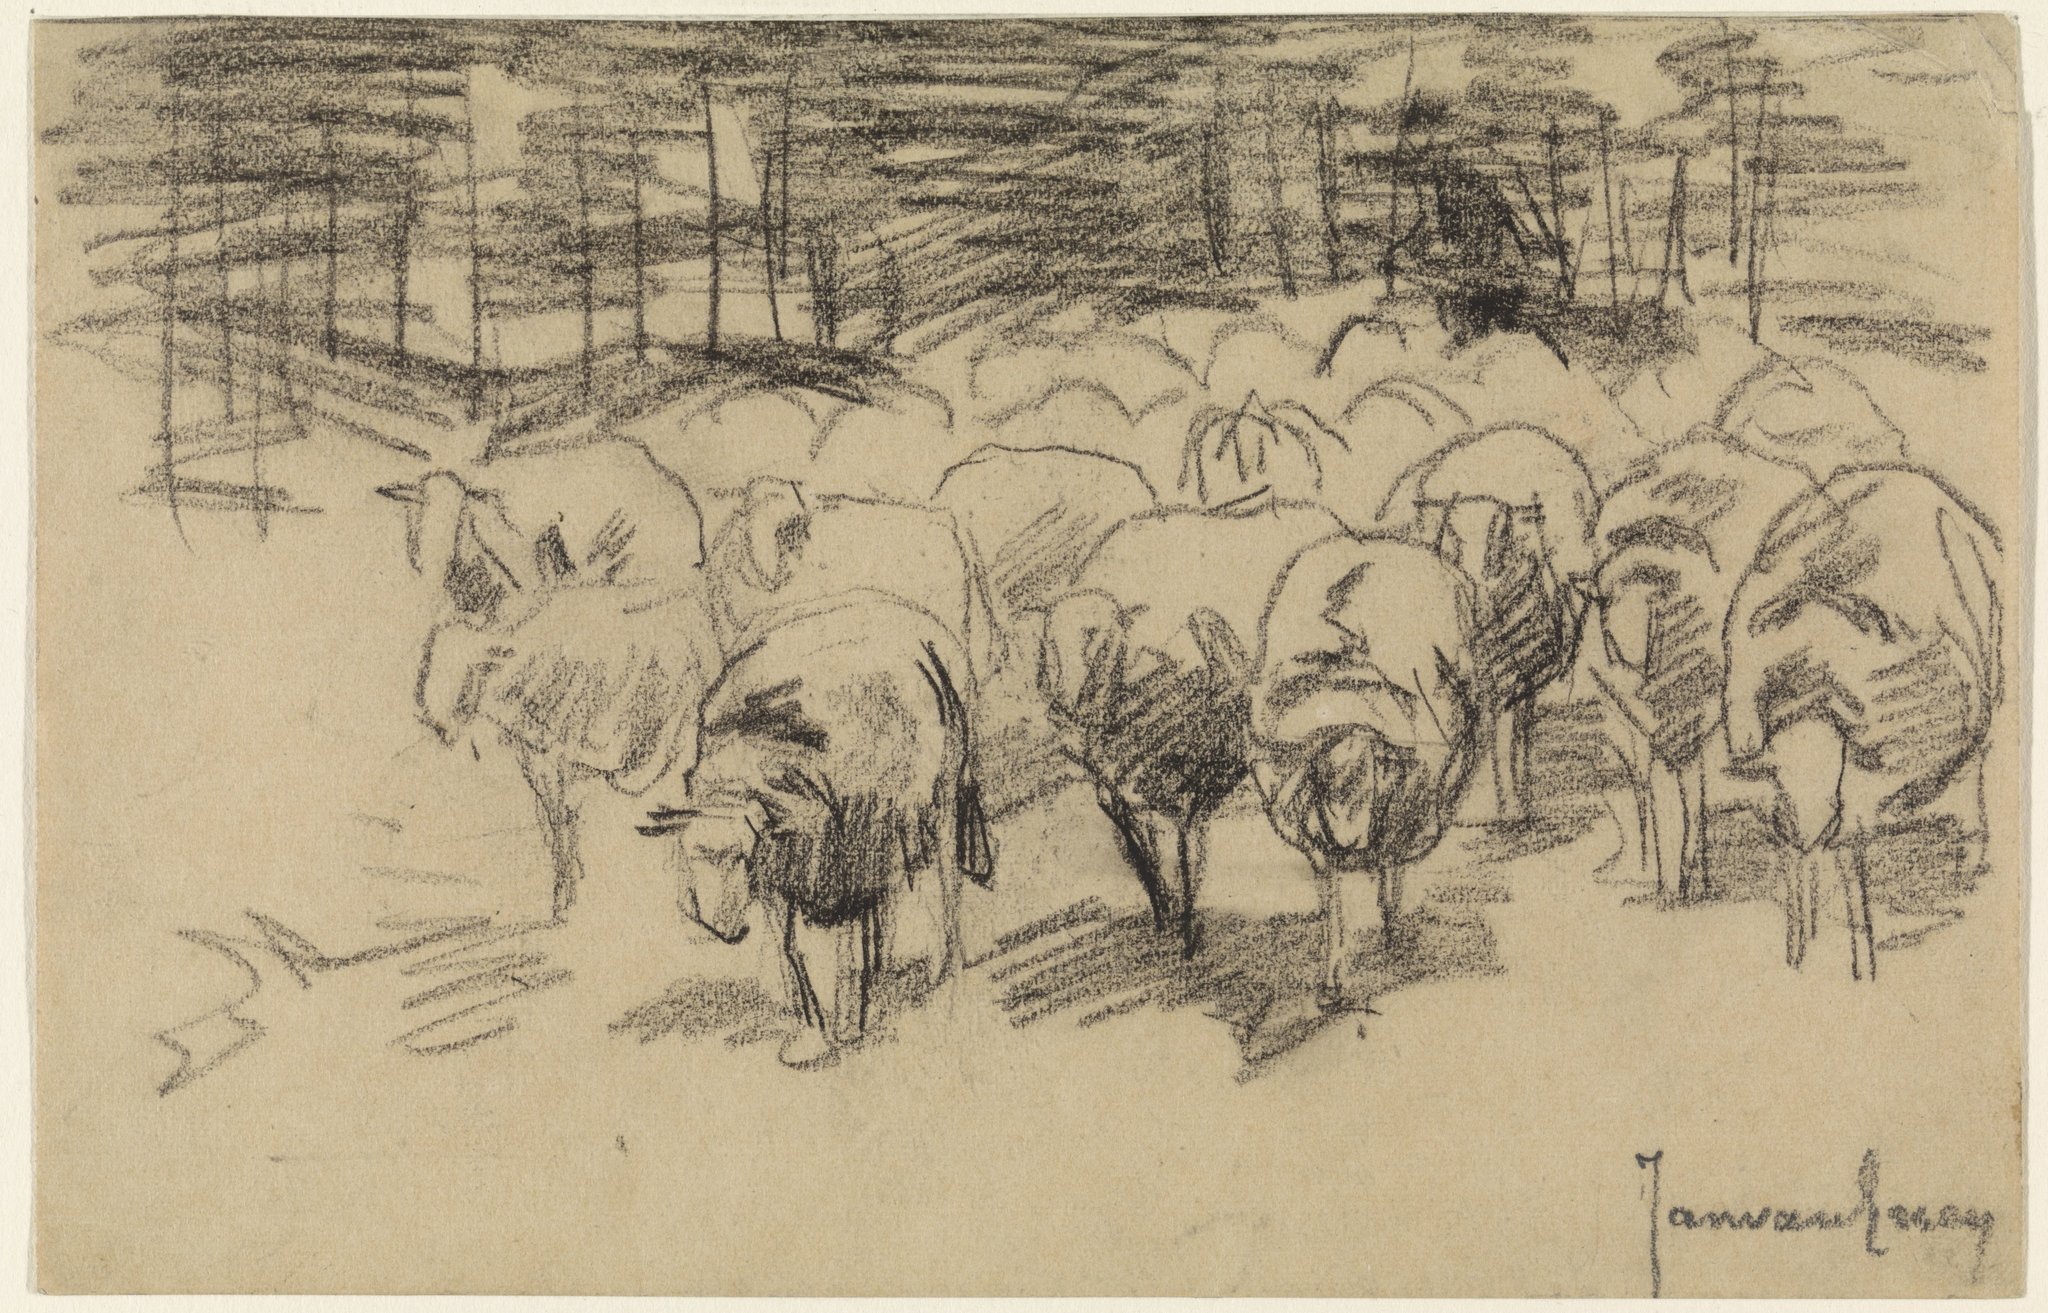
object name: drawing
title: Kudde schapen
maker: jan van essen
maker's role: draughtsman, print maker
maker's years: 1854-1936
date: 1864-1936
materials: chalk, paper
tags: sheep